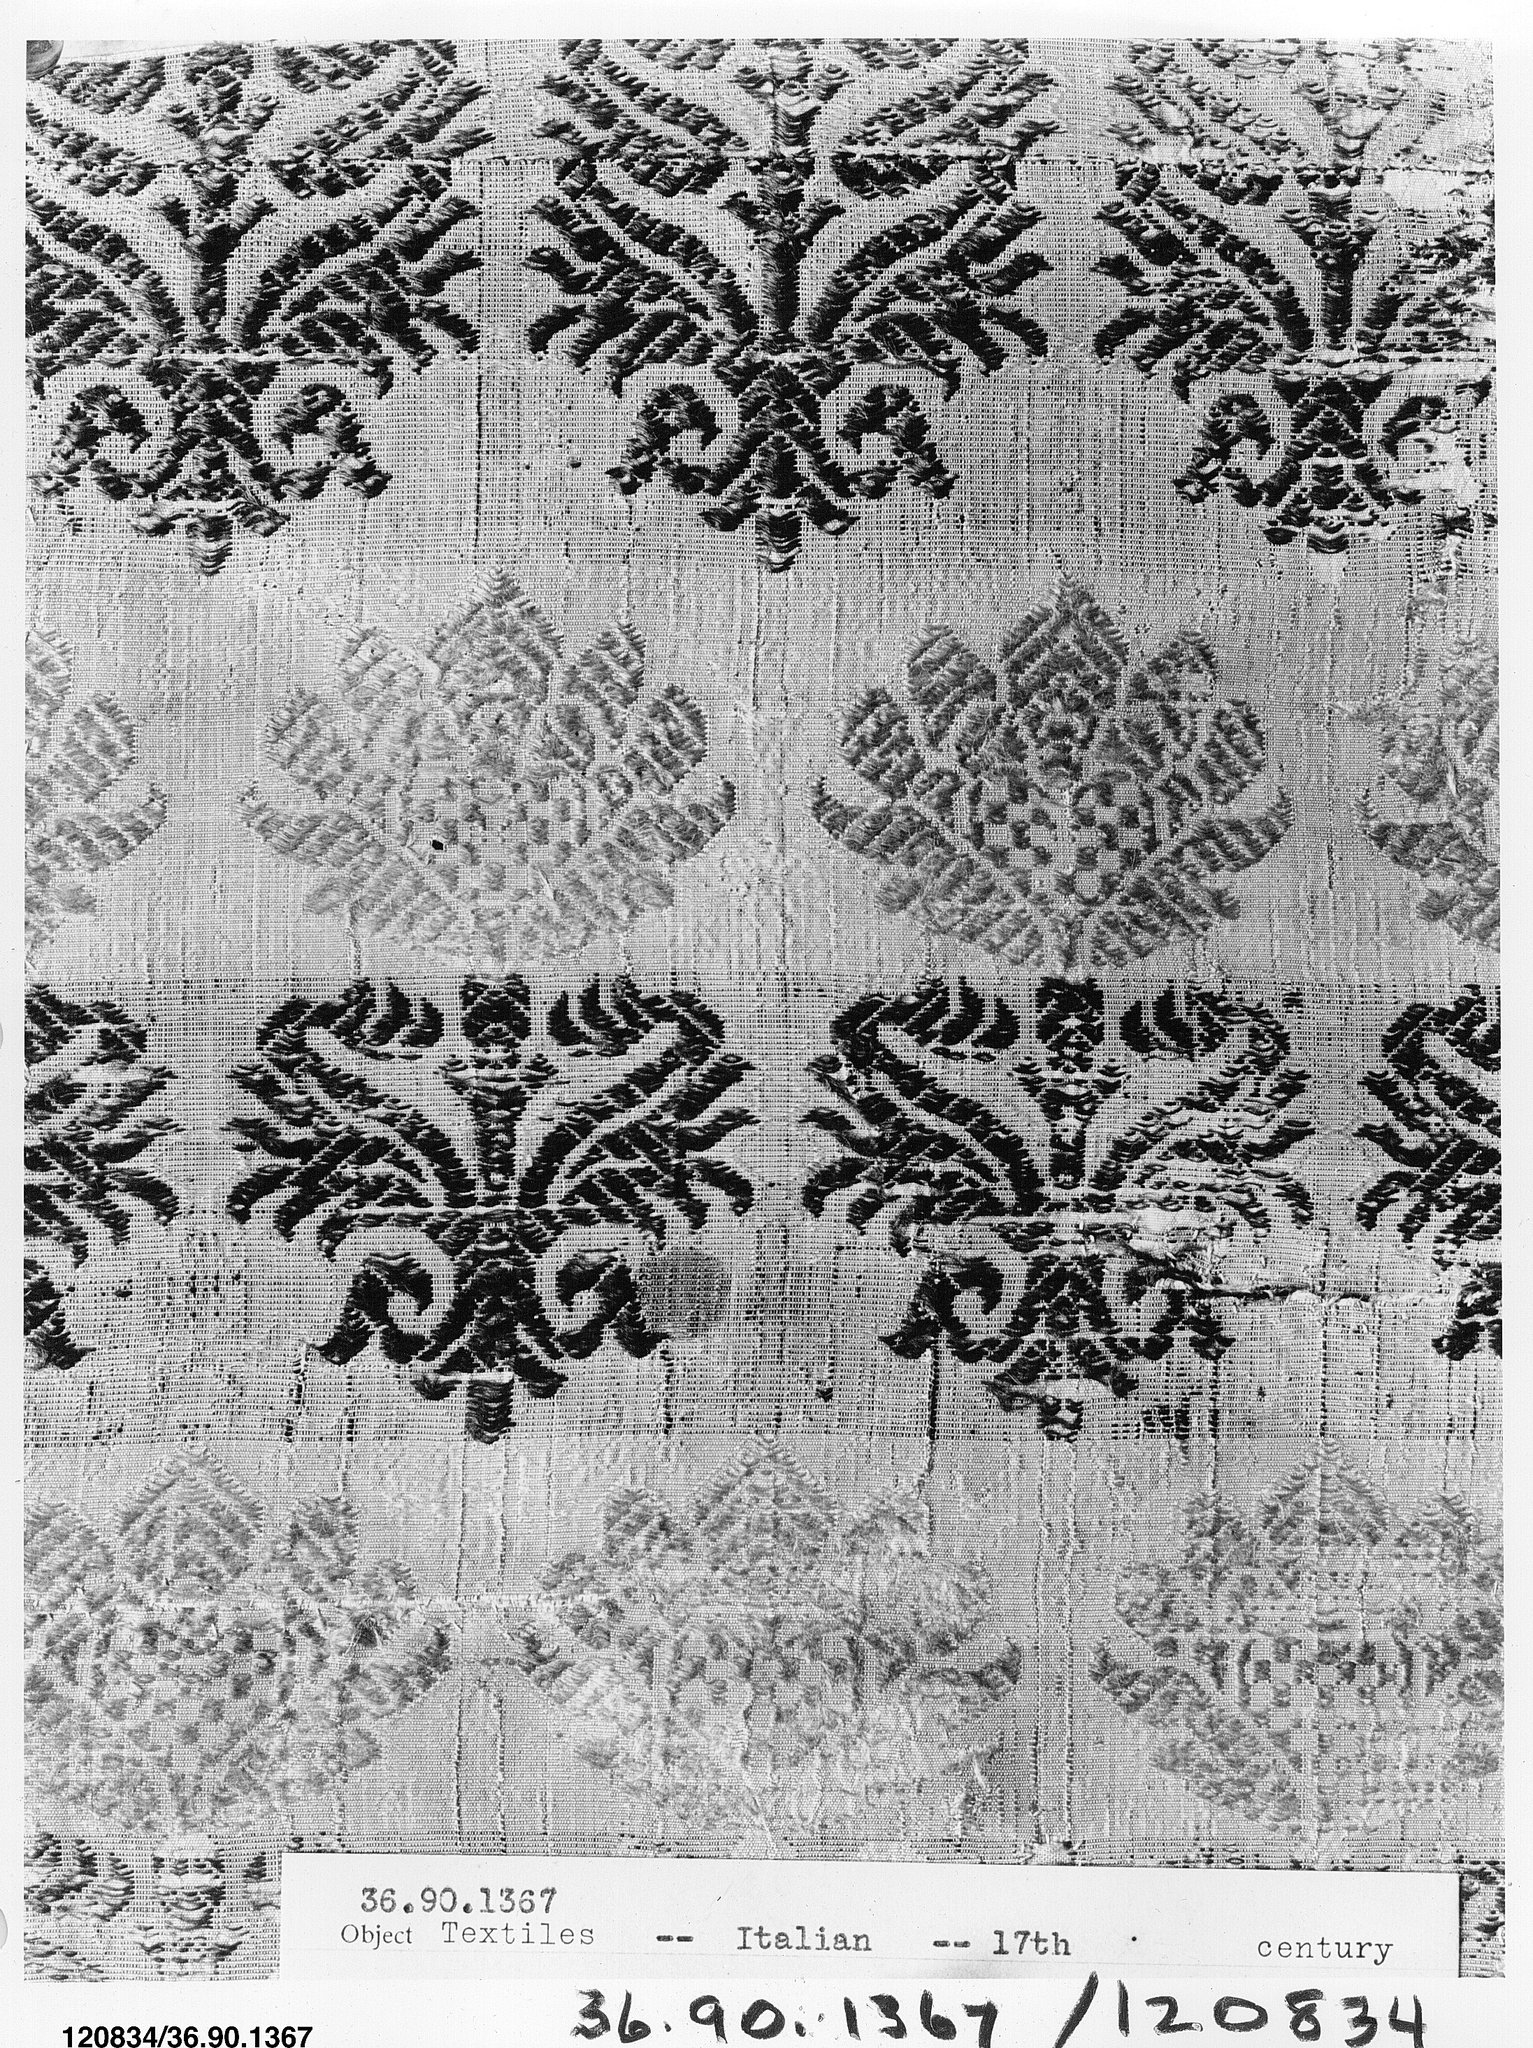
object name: piece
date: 1601-1700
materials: silk